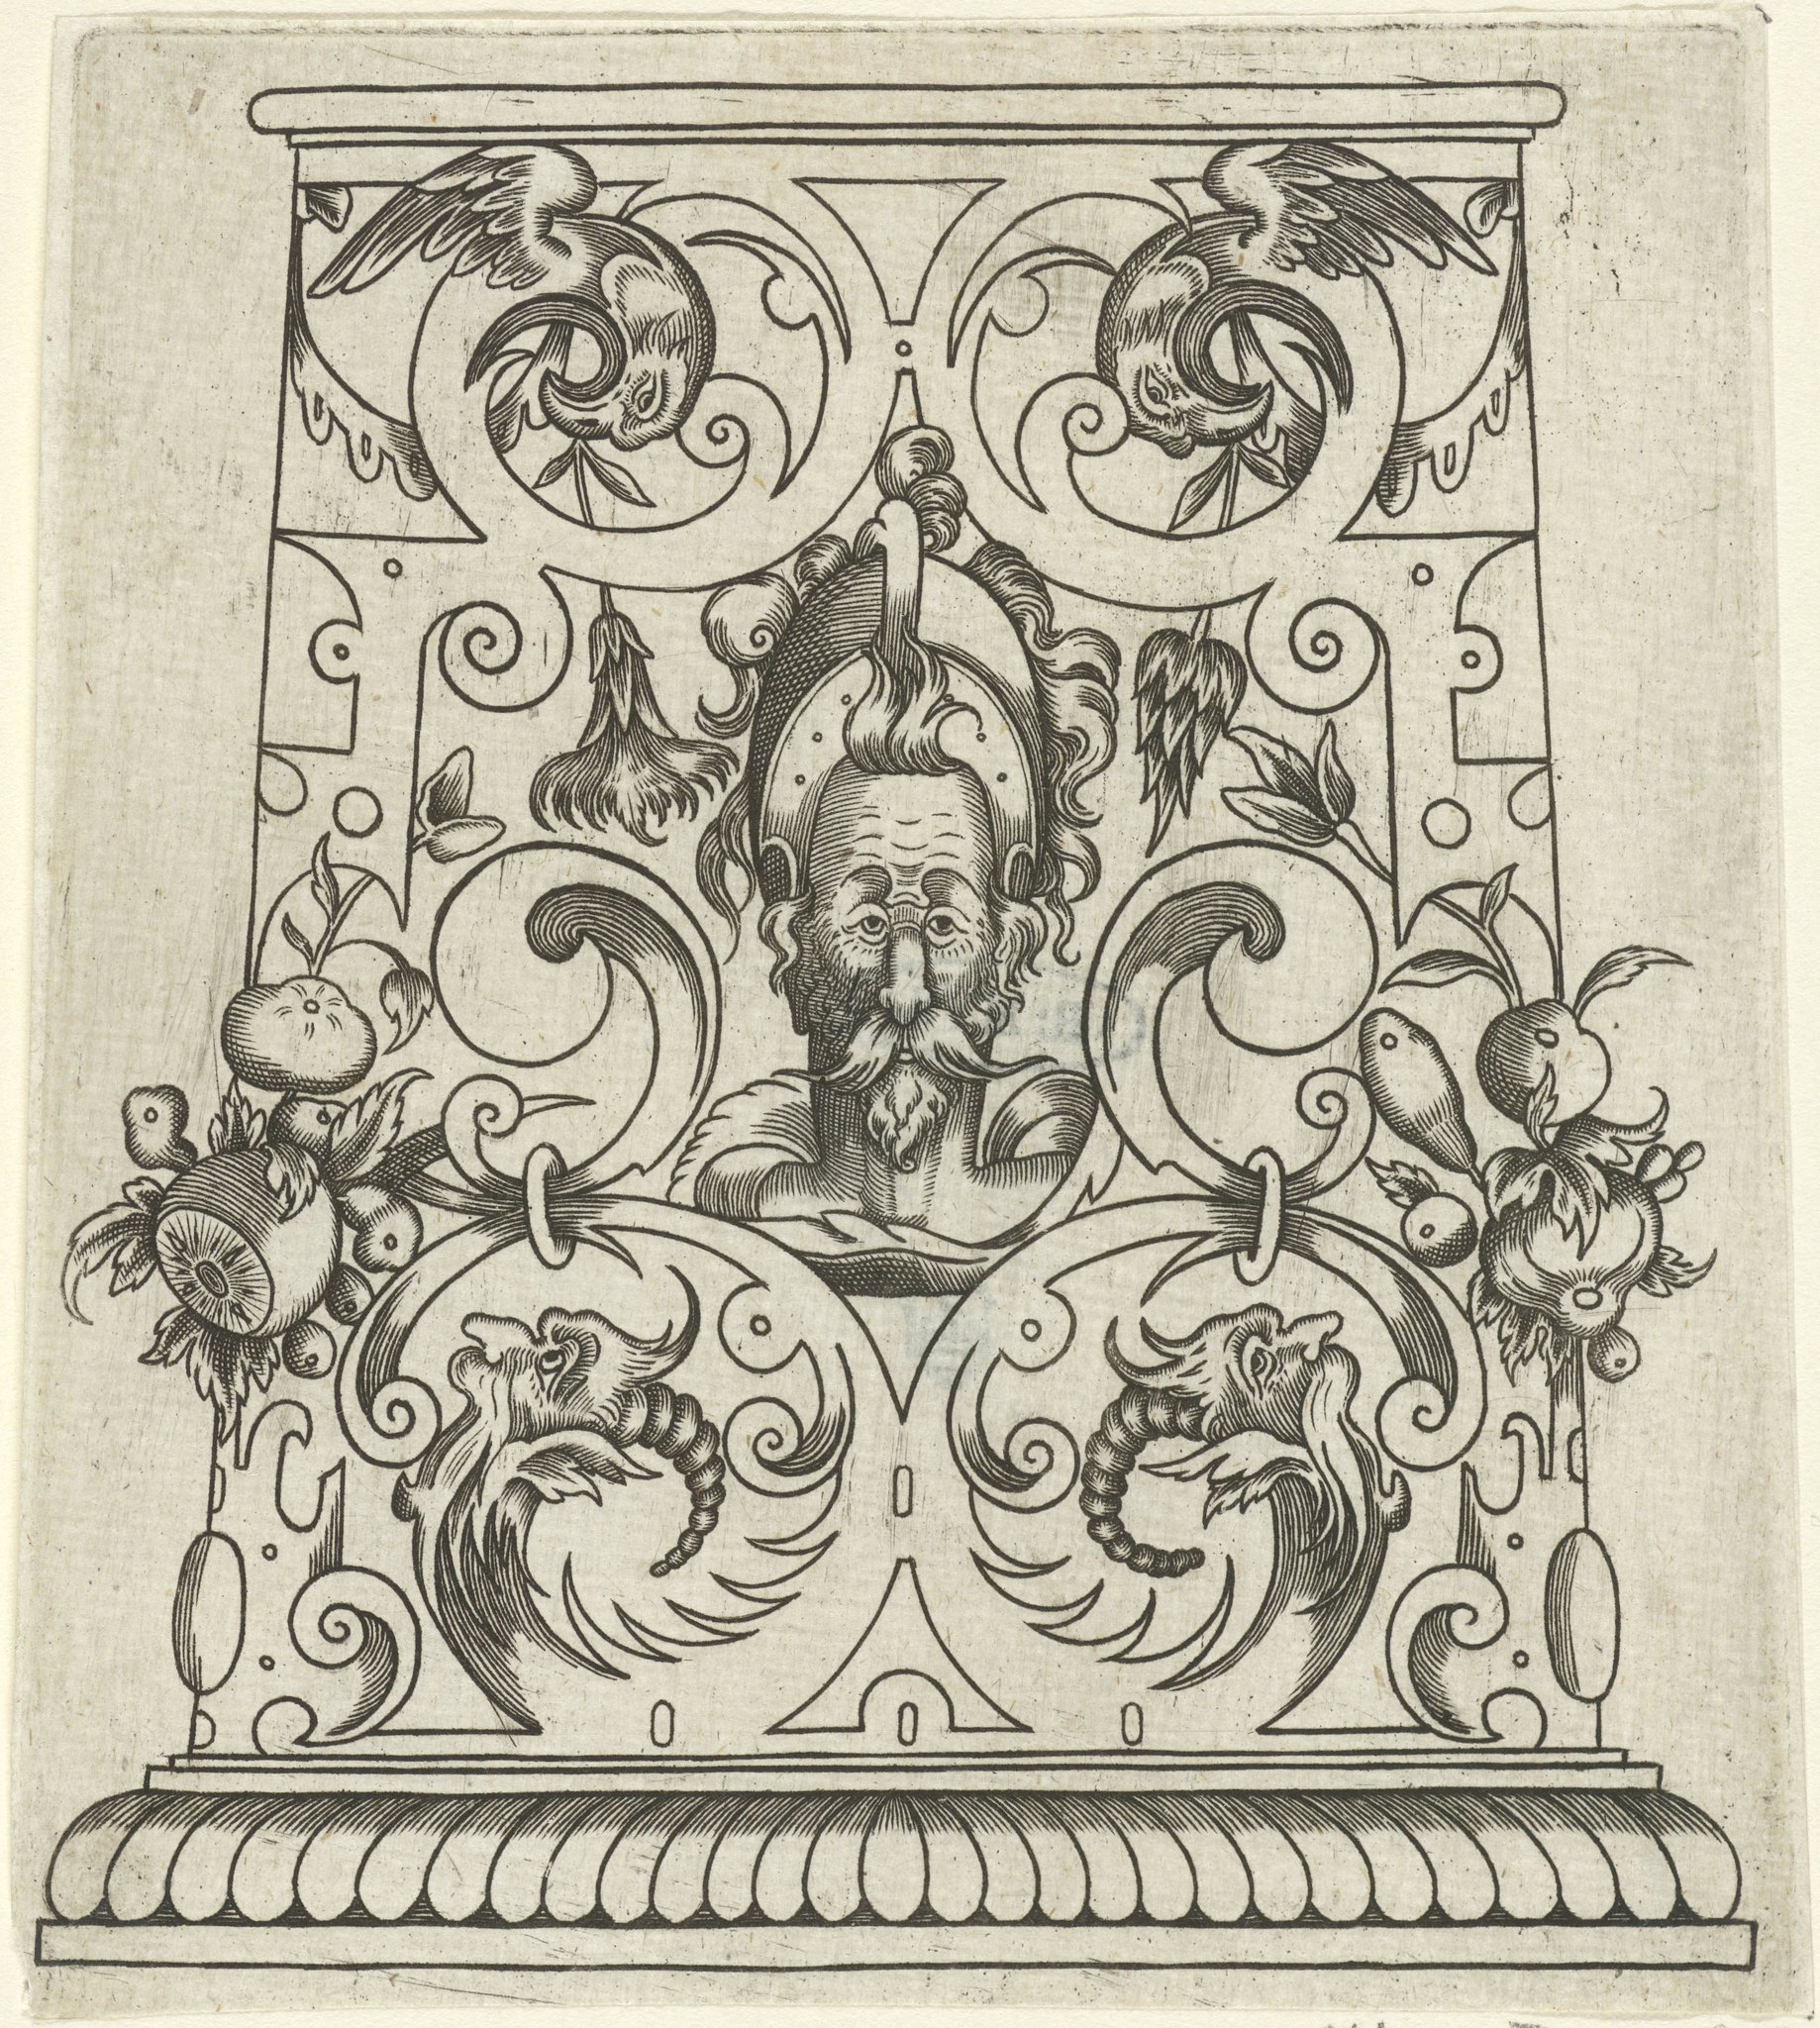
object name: ornament print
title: Serie van 16 Bladen ornamentprenten voor goud- en zilversmeden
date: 1500-1598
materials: paper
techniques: engraving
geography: germany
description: Linksboven en rechtsboven eindigen voluten in vogelkoppen, linksonder en rechtsonder in hoofden van saters. Gelijkzijdige kopieën van de onder Orn Cat I-324 vermelde serie. Titelblad en 13 bladen.